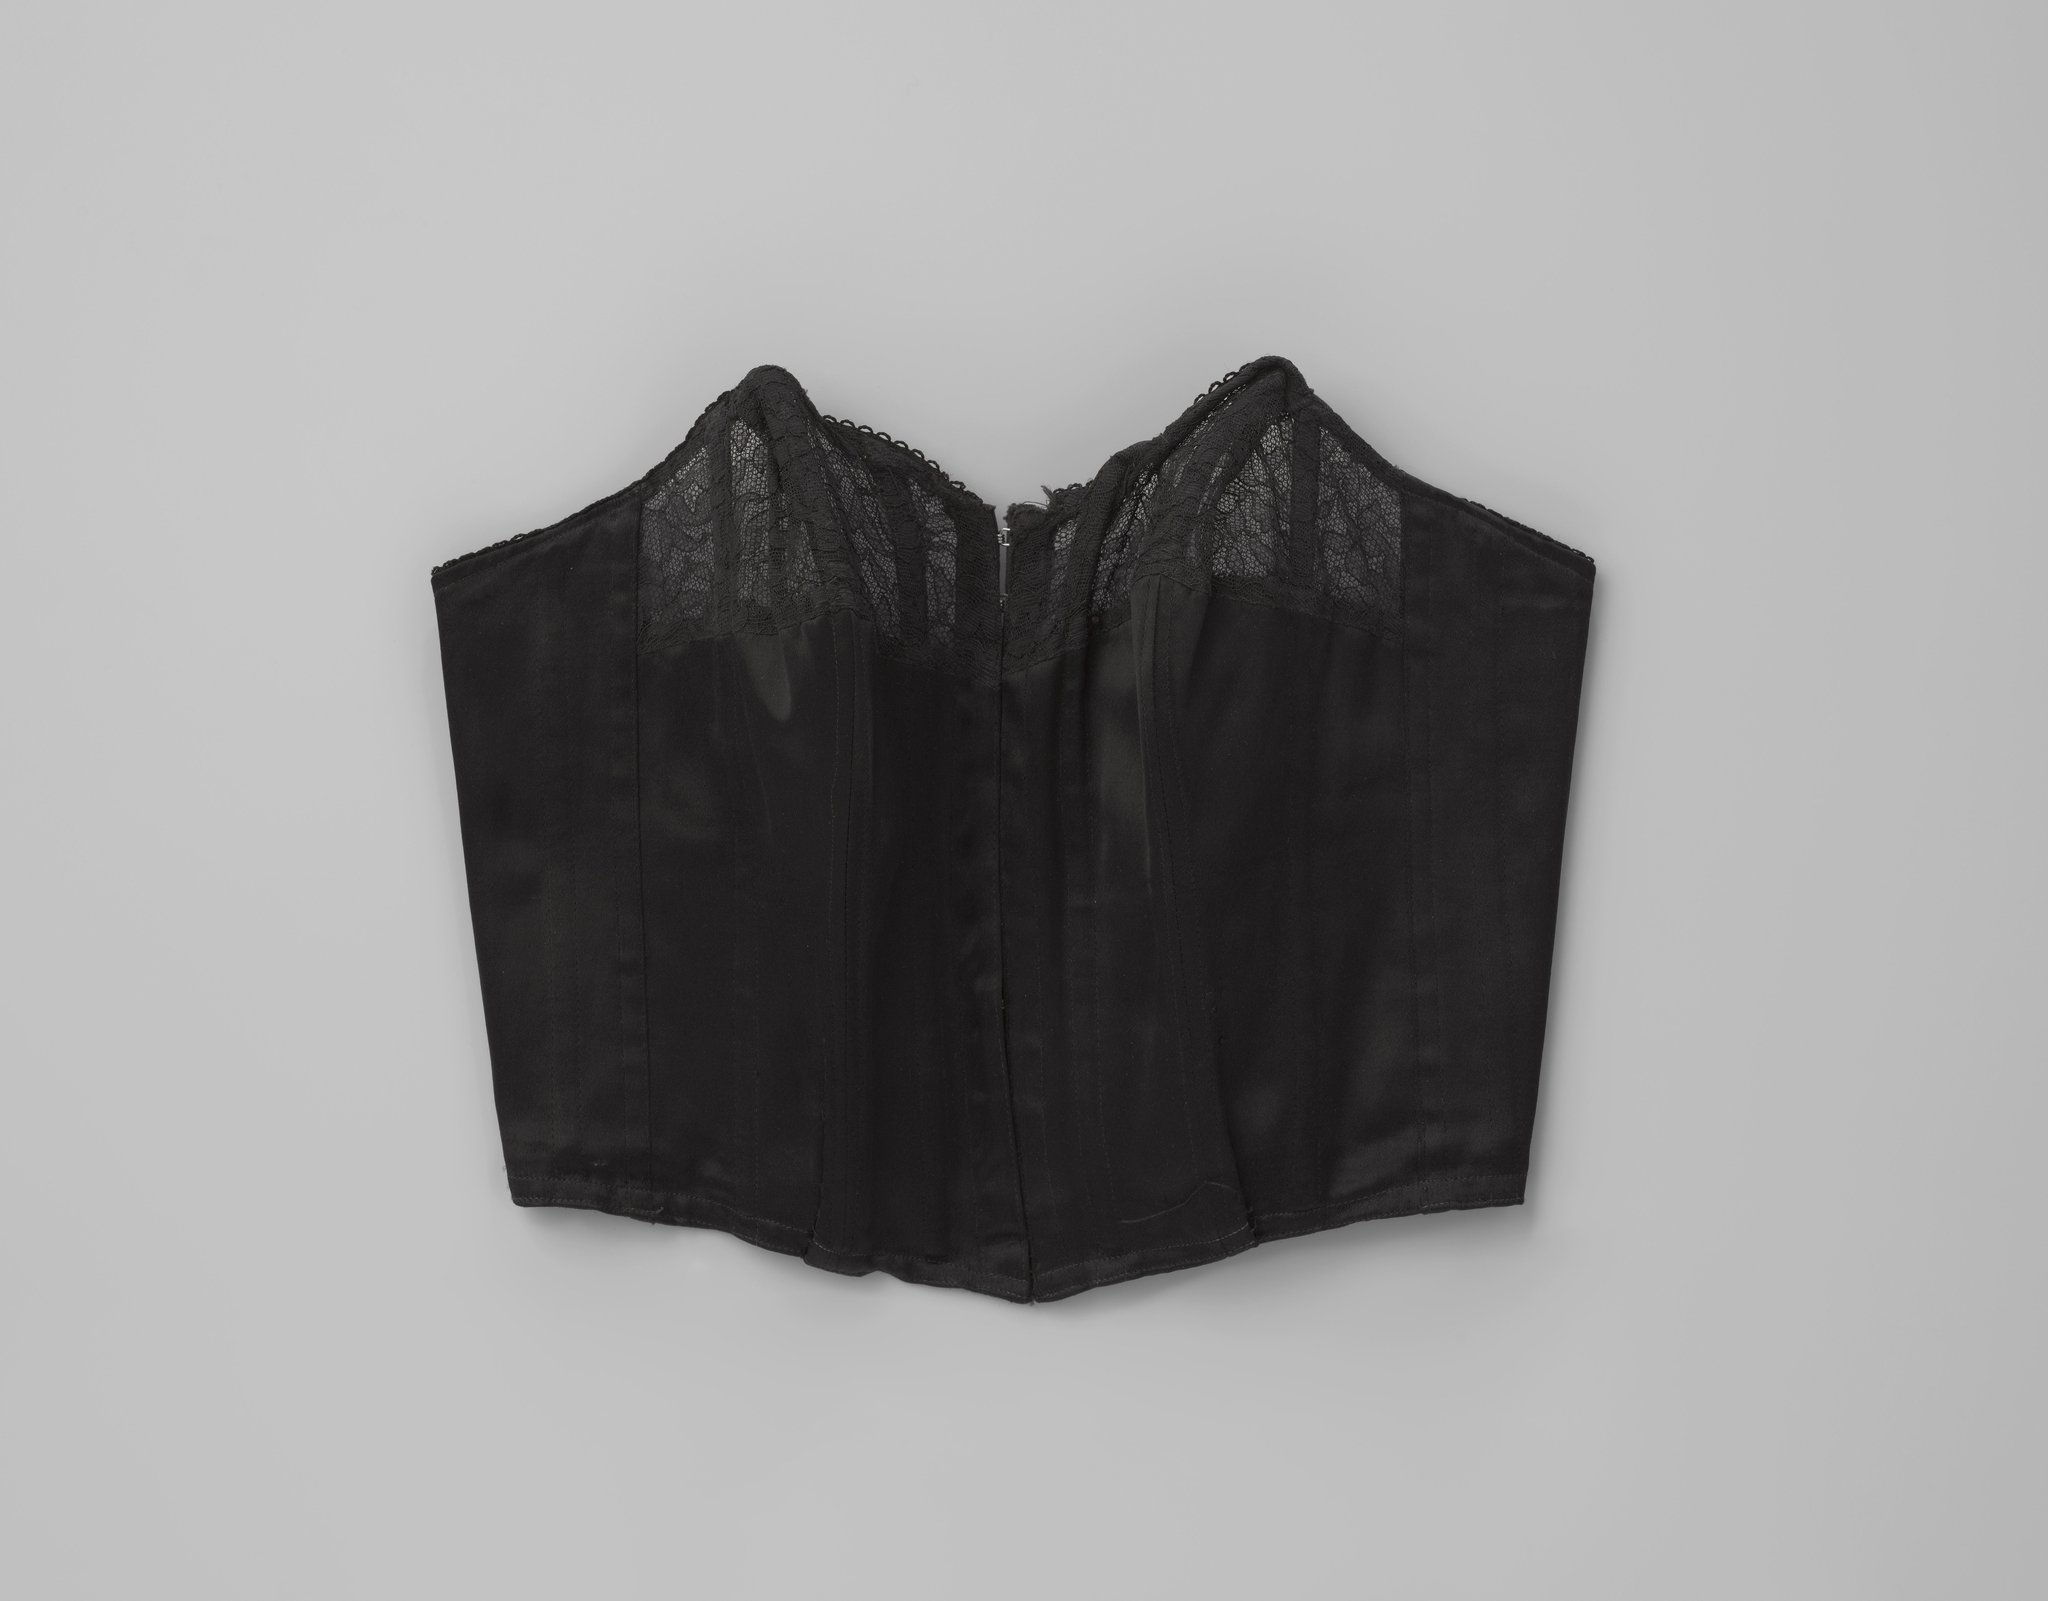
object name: brassiere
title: Beha van zwarte satijn en kant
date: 1930-1940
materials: textile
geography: the hague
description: Beha van zwarte satijn en kant. Bandloos model, voor onder een avondjurk. Van voren is de satijn met een kanten bovenstuk versierd. Baleinen in de voorpanden. Voorsluiting. In de rug een bandelastiek. Adres: Schröder. Corsela Wett. Ged.